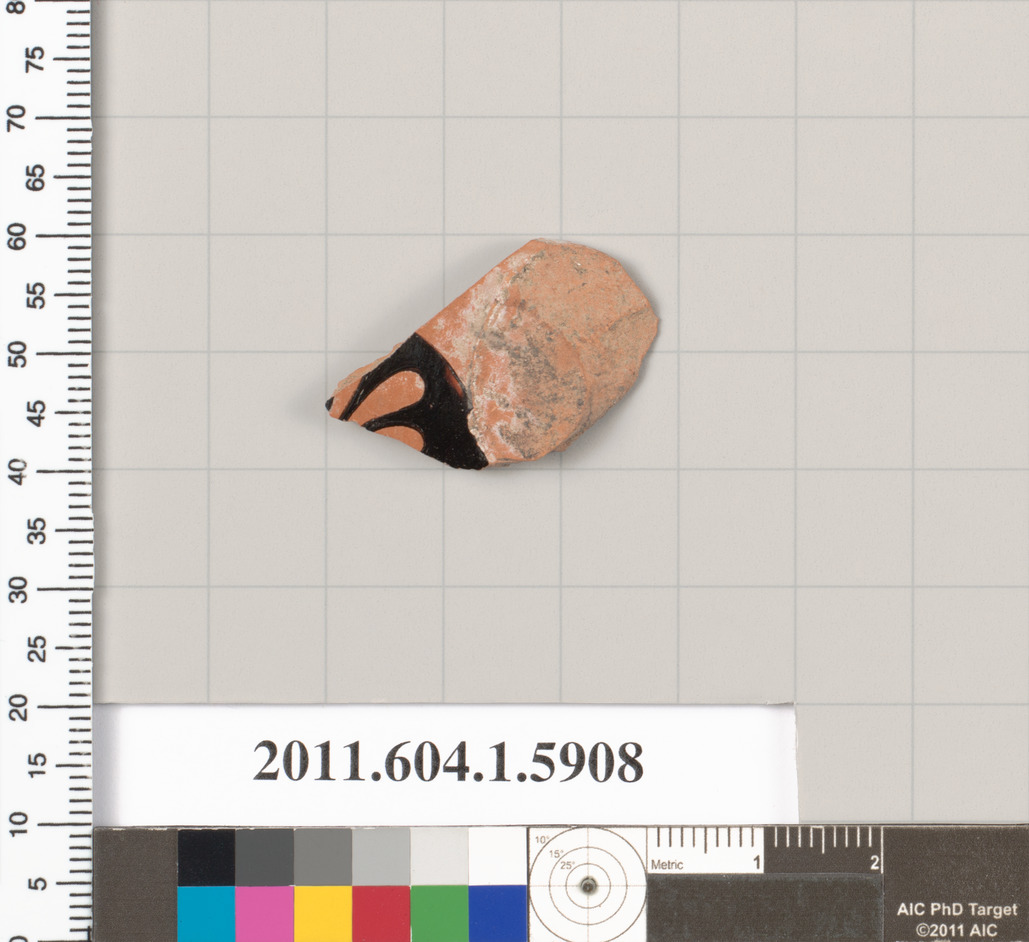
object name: kylix fragment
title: Terracotta fragment of a kylix (drinking cup)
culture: greek, attic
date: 520-510 BCE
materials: terracotta